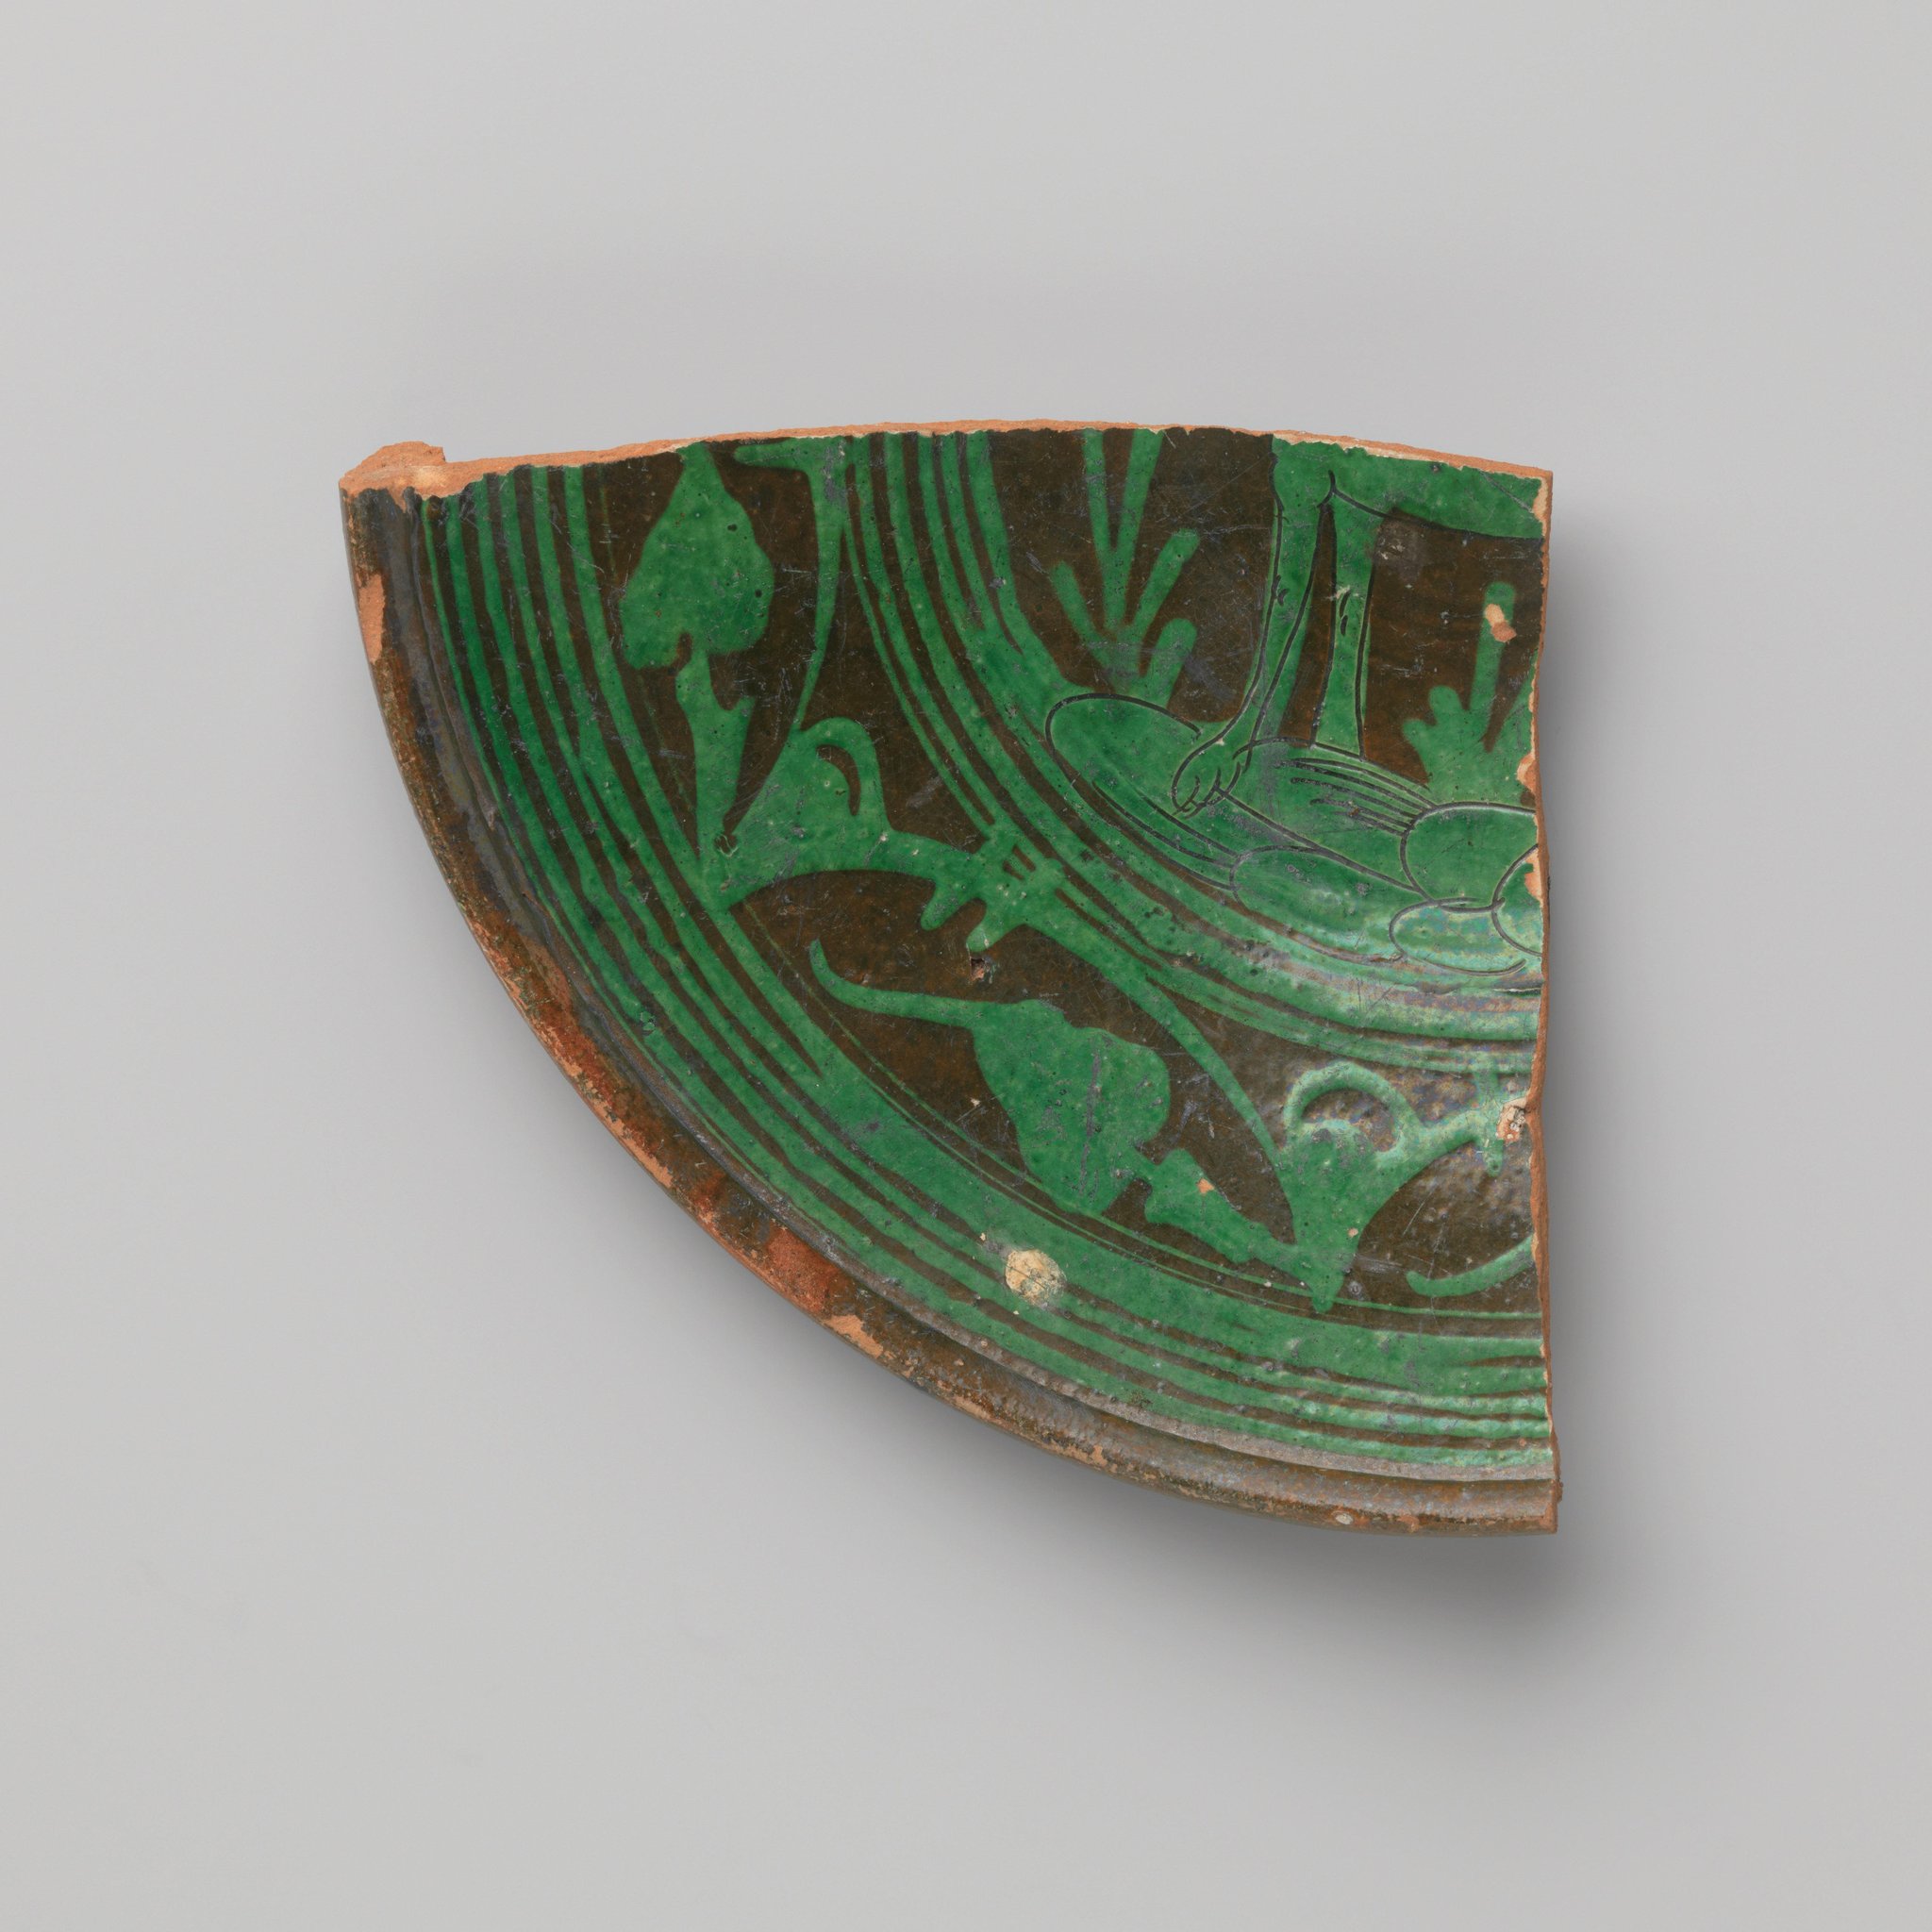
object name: platter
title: Fragment van een schotel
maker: Anonymous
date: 1590-1620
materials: earthenware, glaze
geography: wanfried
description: Fragment van een schotel van loodglazuuraardewerk. Het fragment heeft een donkere fond en is met groen gedecoreerd. Op het plat is een dier (hert) geschilderd, waarvan alleen de poten en de buik aanwezig zijn, en op de rand bladeren.